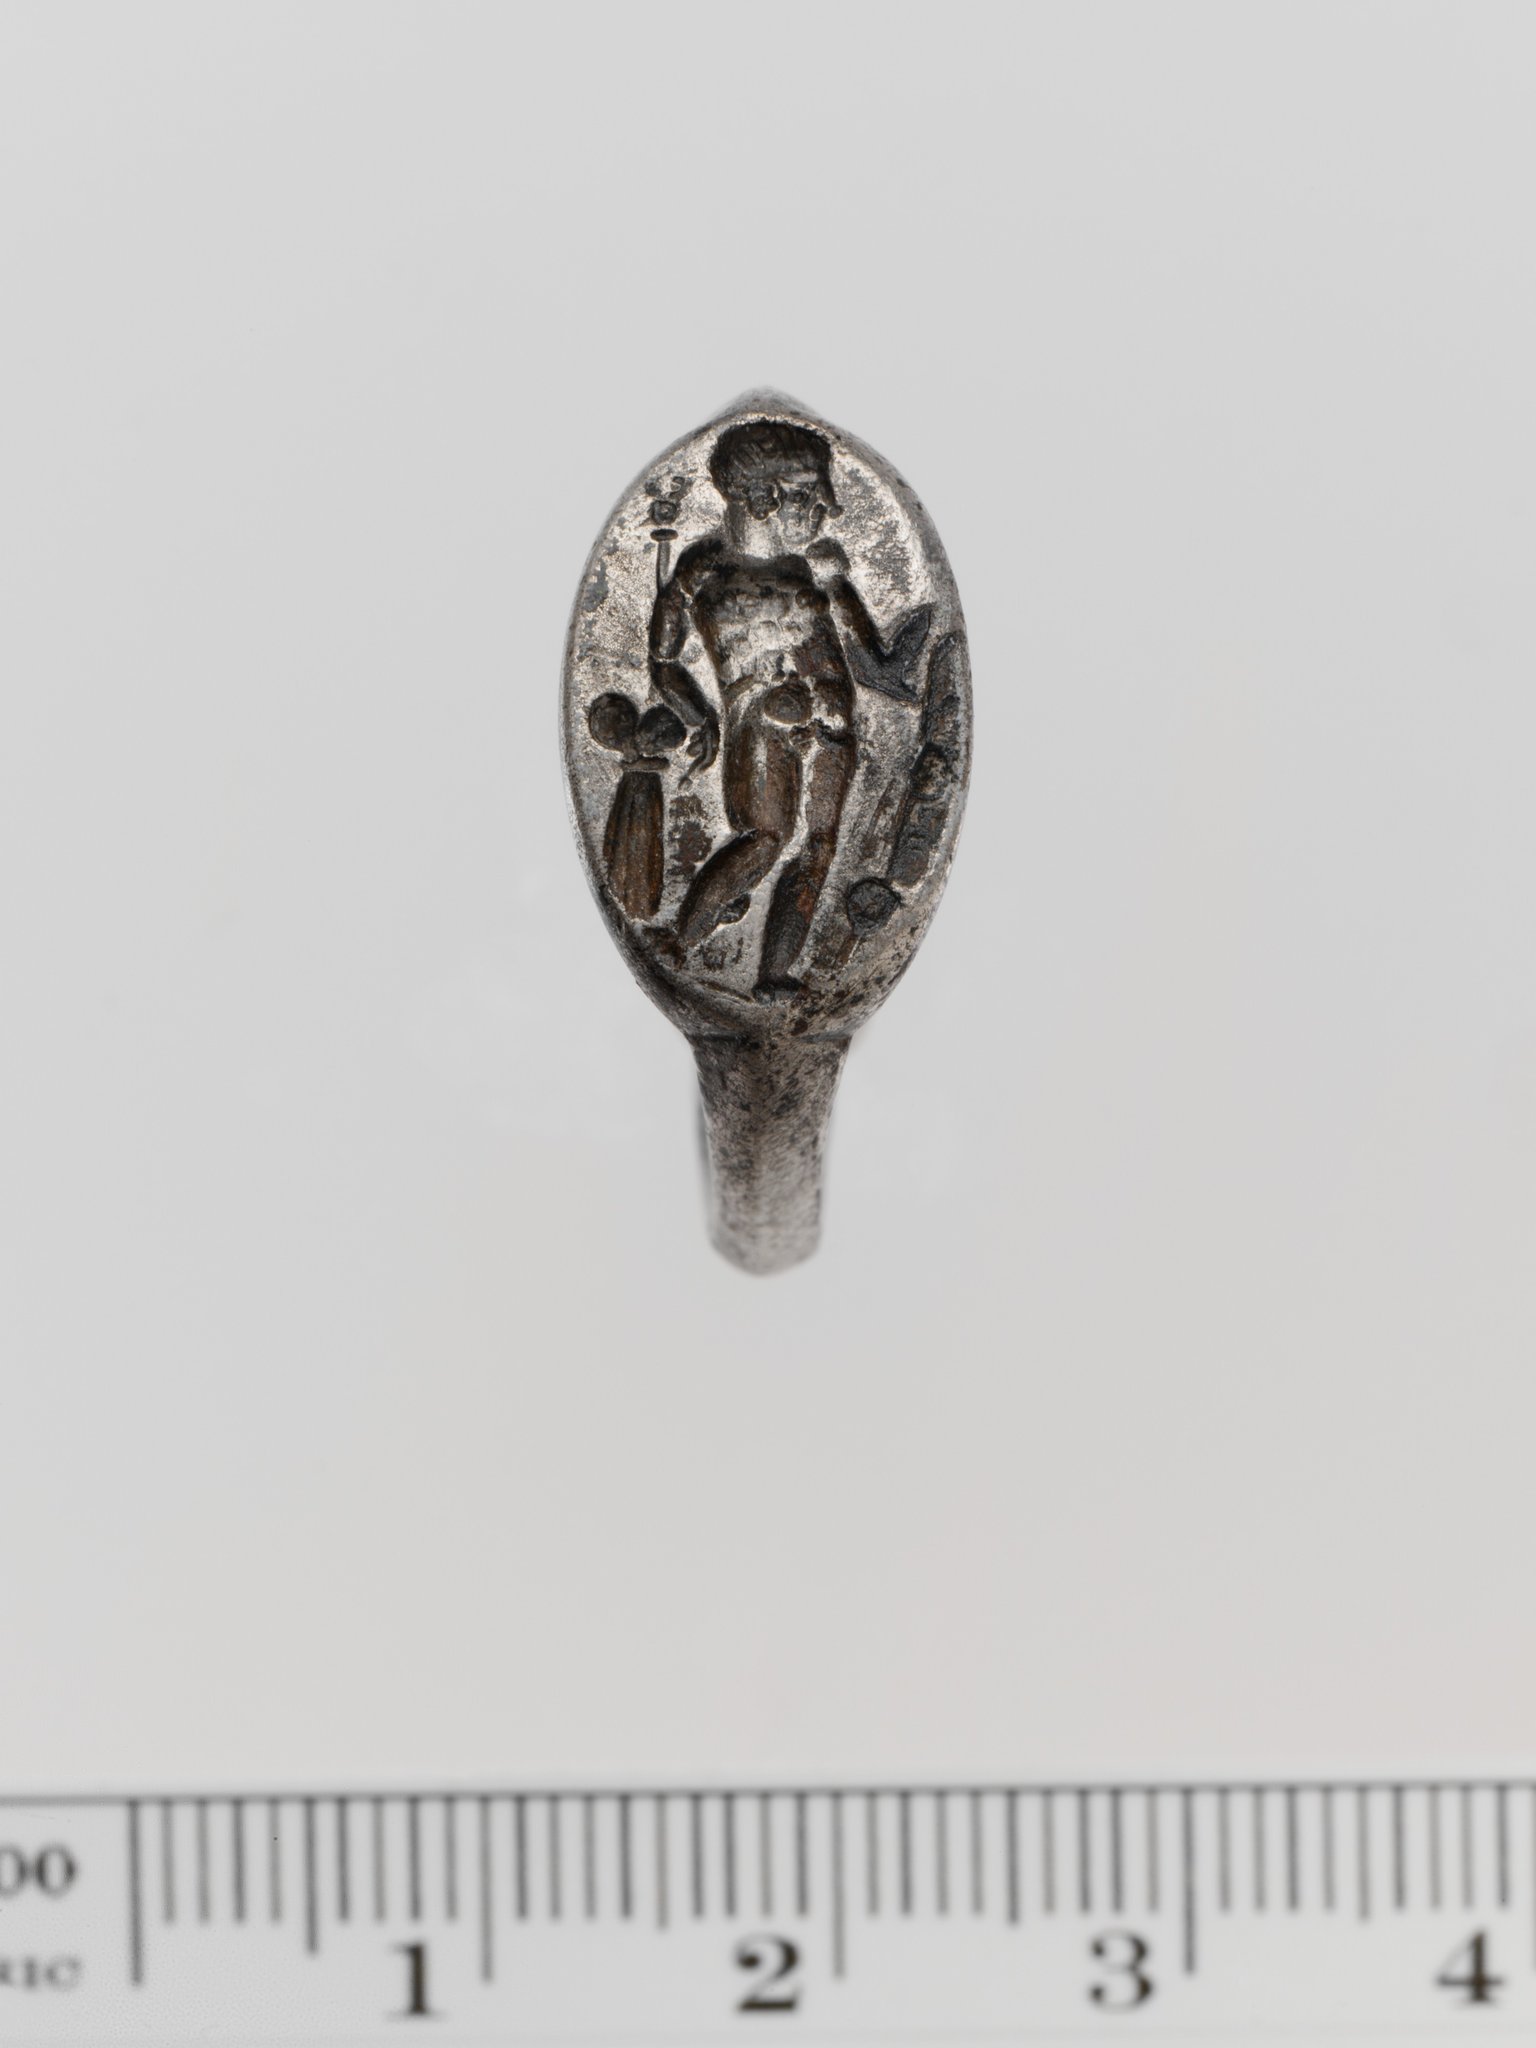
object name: ring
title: Silver ring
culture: greek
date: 434-401 BCE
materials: silver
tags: hermes